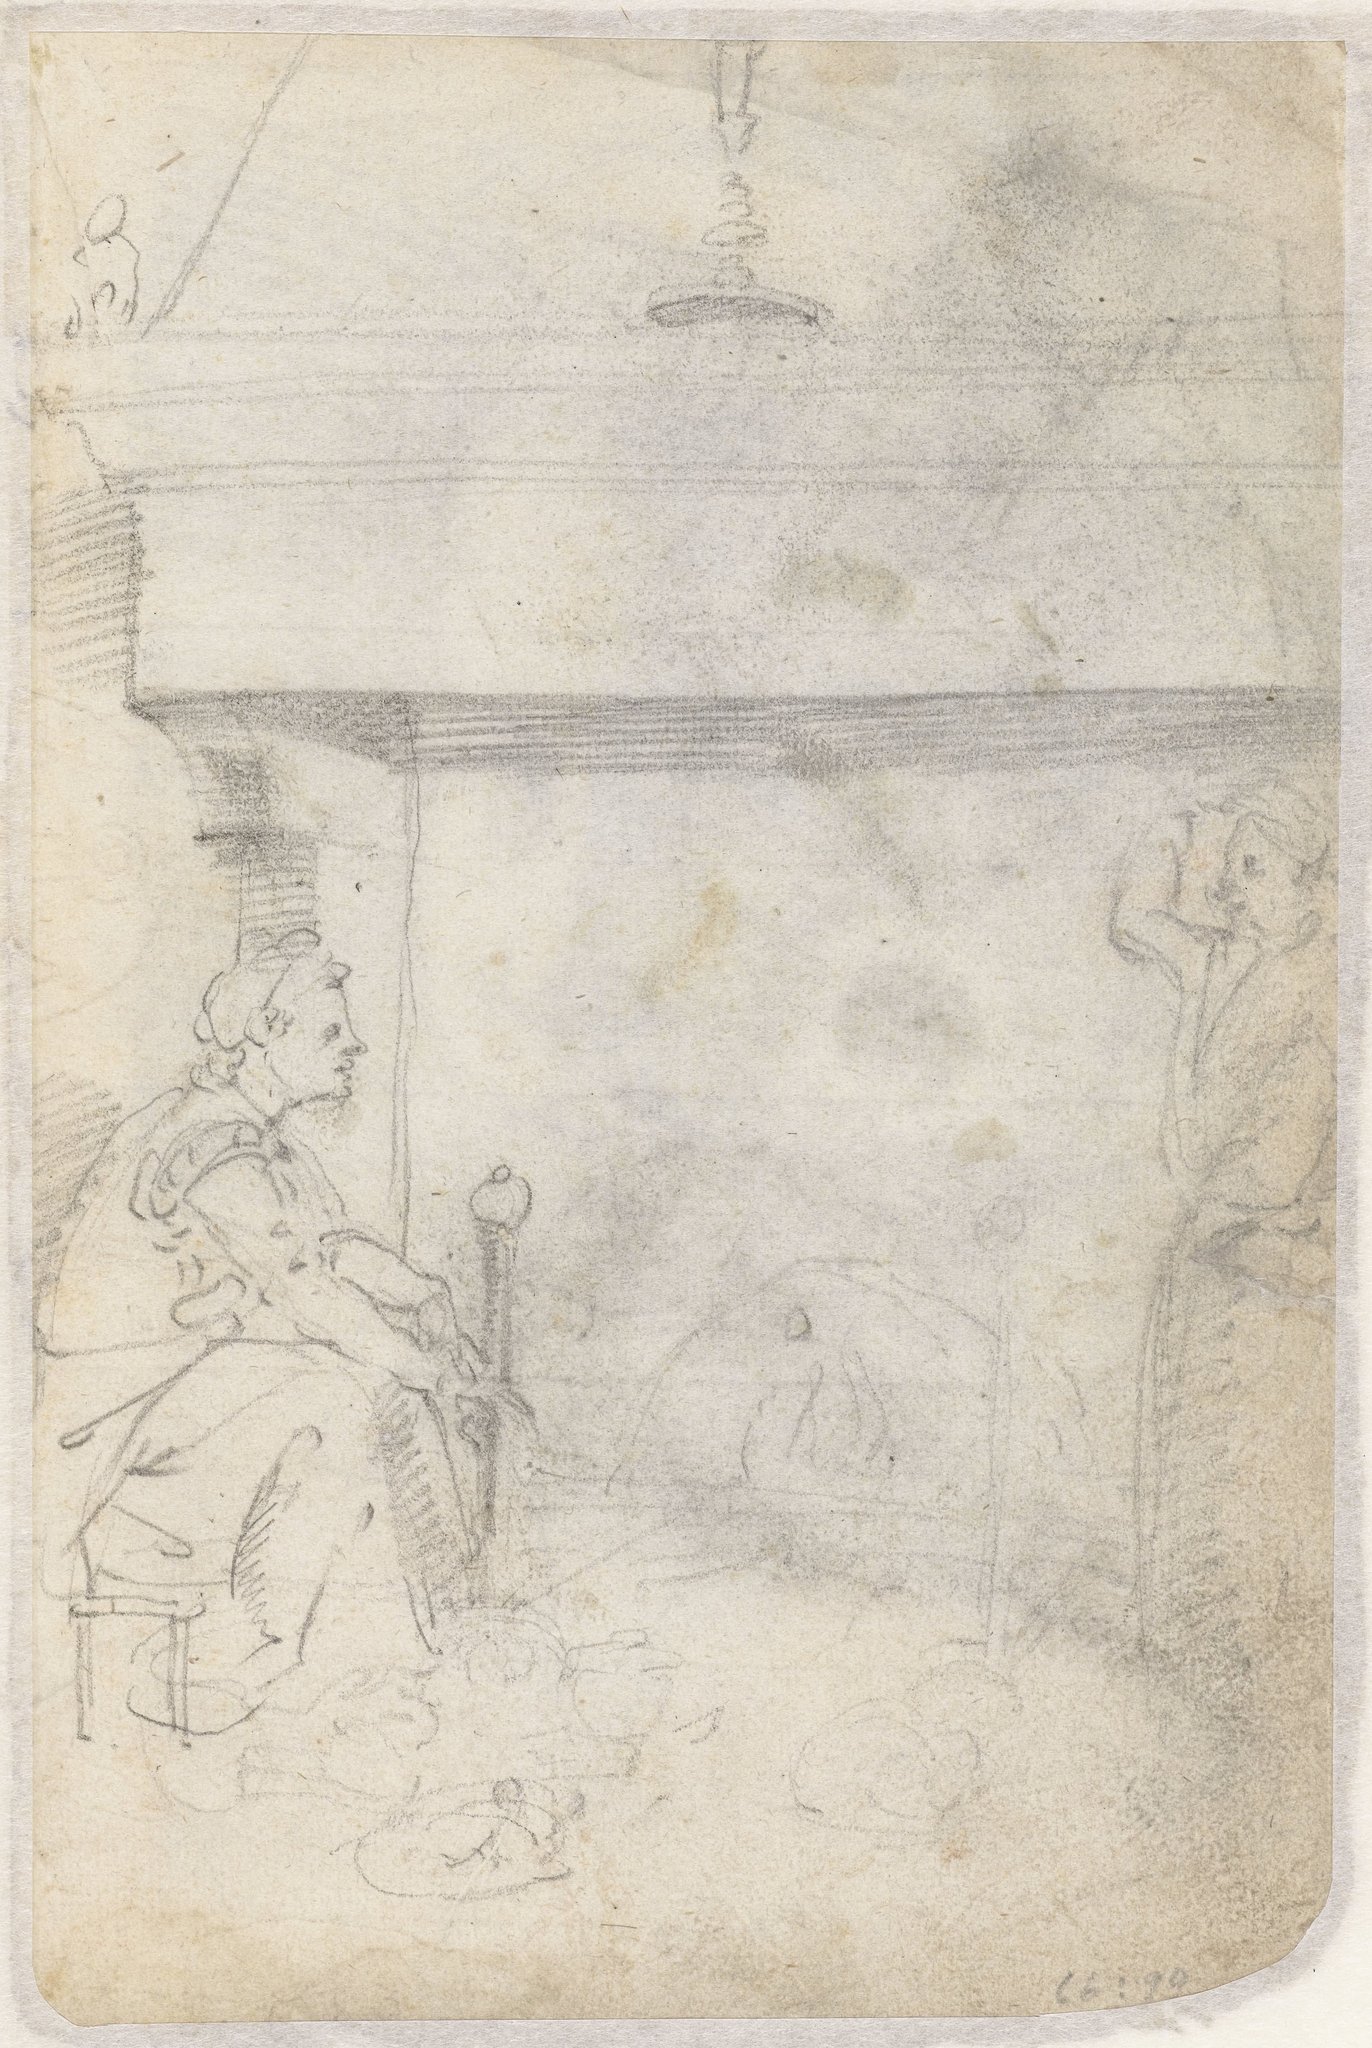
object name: drawing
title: Twee personen bij een schouw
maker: domenico beccafumi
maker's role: draughtsman, painter, print maker, sculptor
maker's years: 1486-1551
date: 1519-1547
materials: chalk, paper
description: Blad uit schetsboek van Domenico Beccafumi.